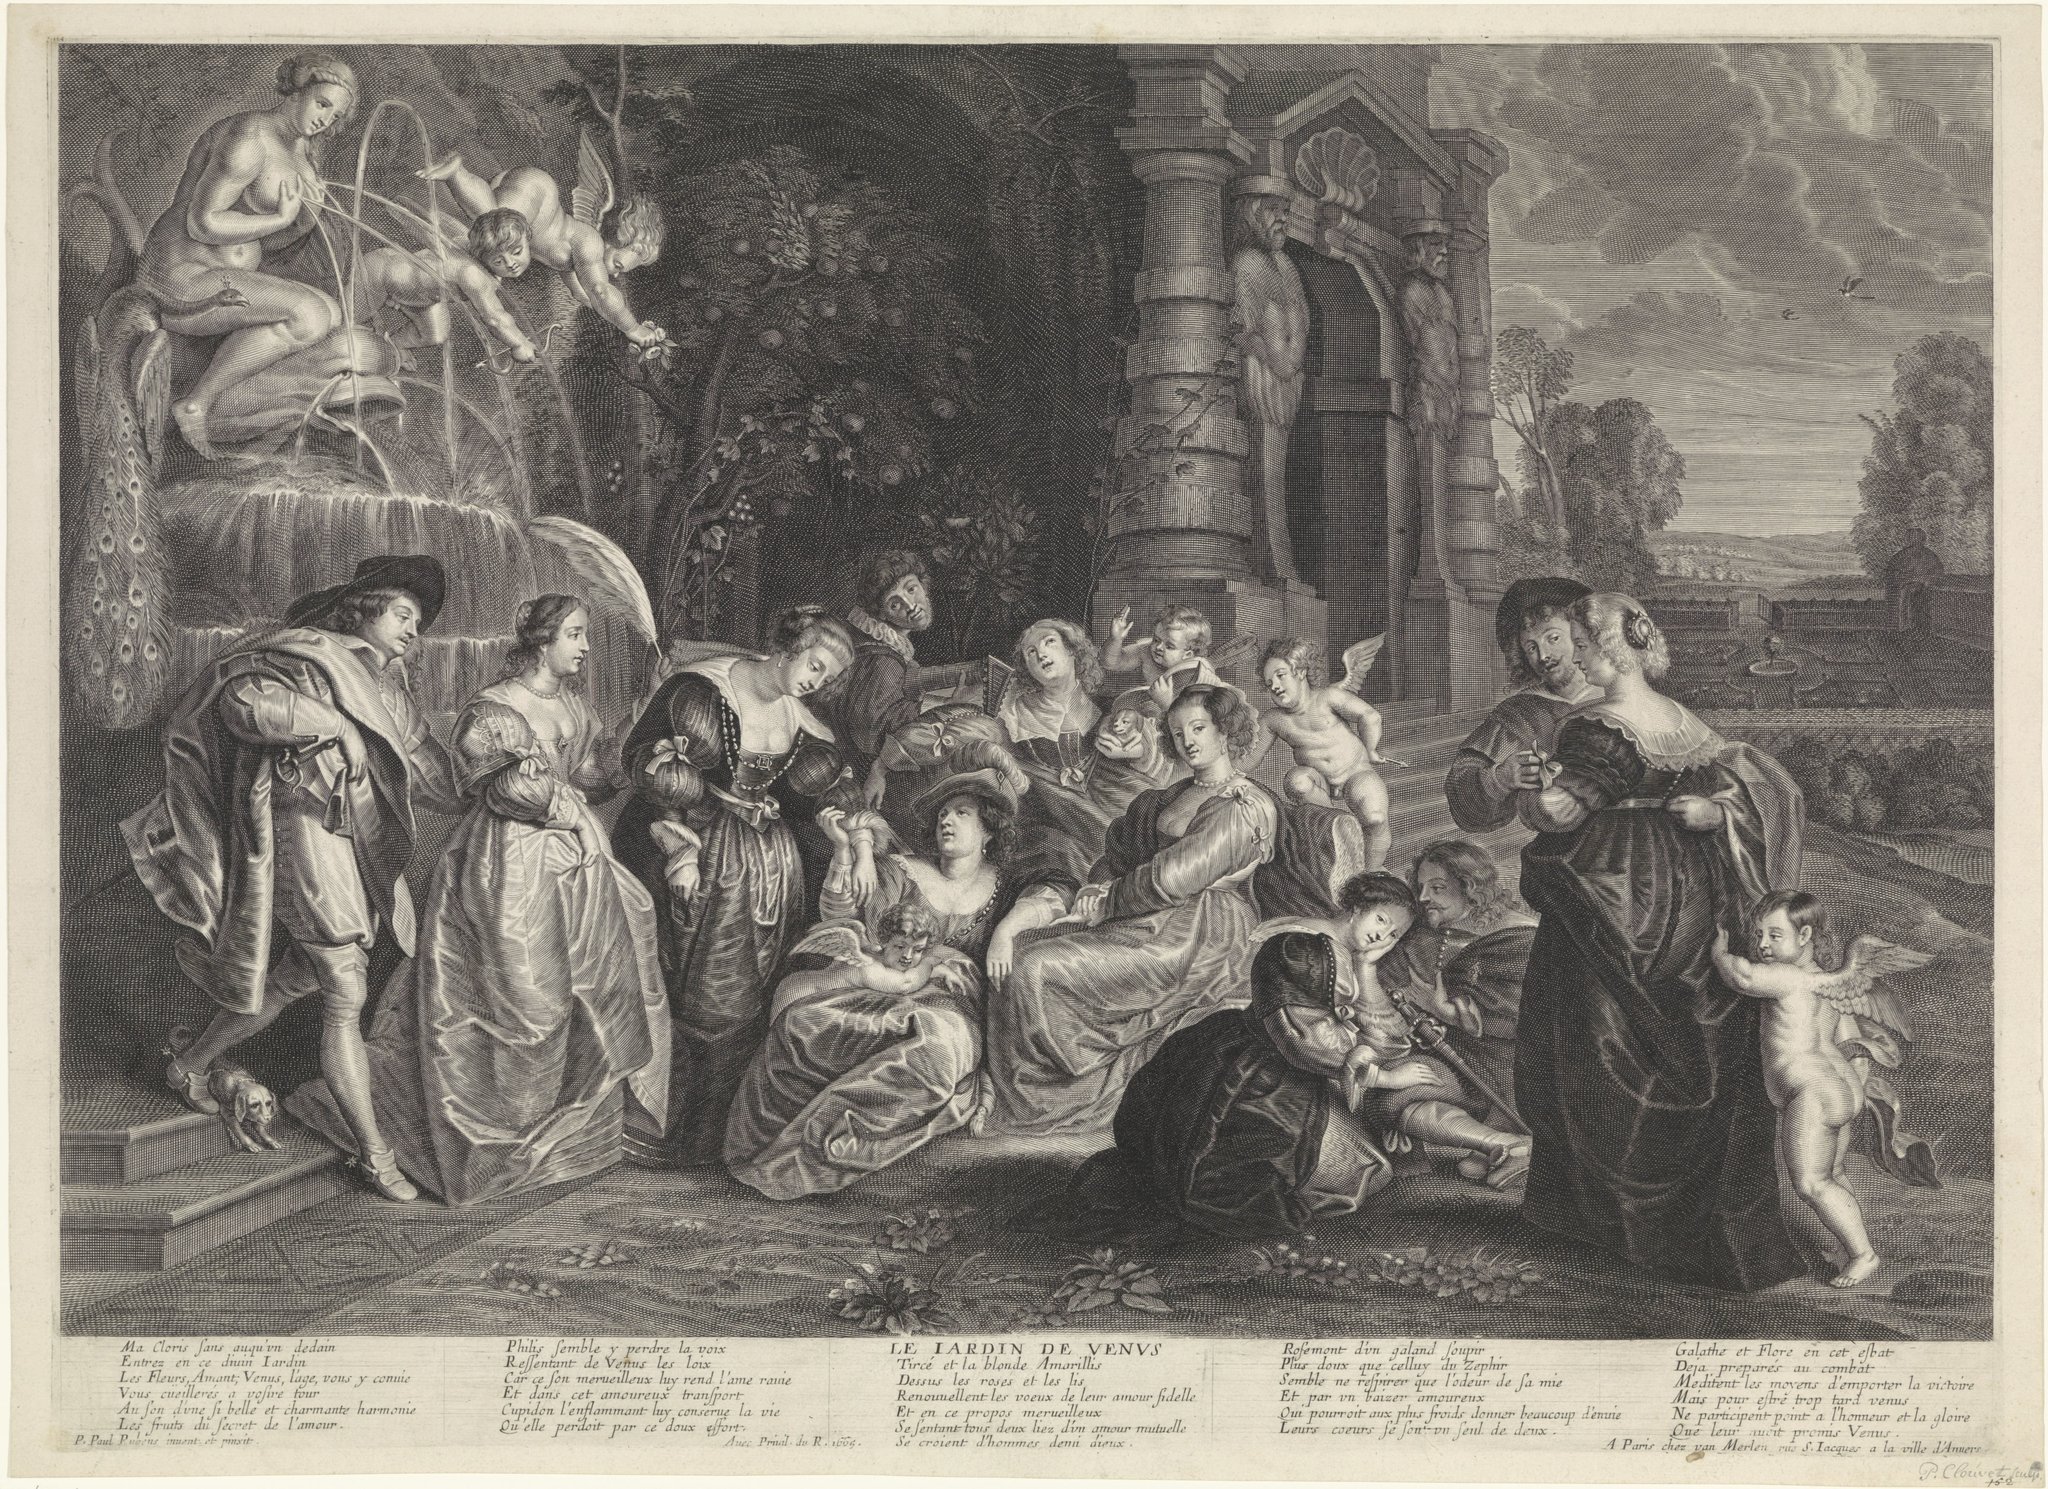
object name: print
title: Tuin der Liefde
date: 1665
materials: paper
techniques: engraving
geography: antwerp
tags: garden fountain, one pair dancing; man and woman dancing as a couple, french or architectonic garden; formal garden, garden of love, court of love, 'fête galante', (story of) venus (aphrodite), cupids: 'amores', 'amoretti', 'putti'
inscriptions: number: ‘152’, collector's mark: Lugt 240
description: Een gezelschap van mannen en vrouwen zit in de tuin der liefde naast een fontein. Er wordt muziek gespeeld. Een paar rechts probeert te dansen. Cupido's verzamelen zich rondom het gezelschap. Bovenop de fontein zit Venus op een dolfijn. Uit haar borsten stroomt water. Naast haar zit een pauw. Op de achtergrond een architectonische tuin. De prent heeft een Frans gedicht als onderschrift.